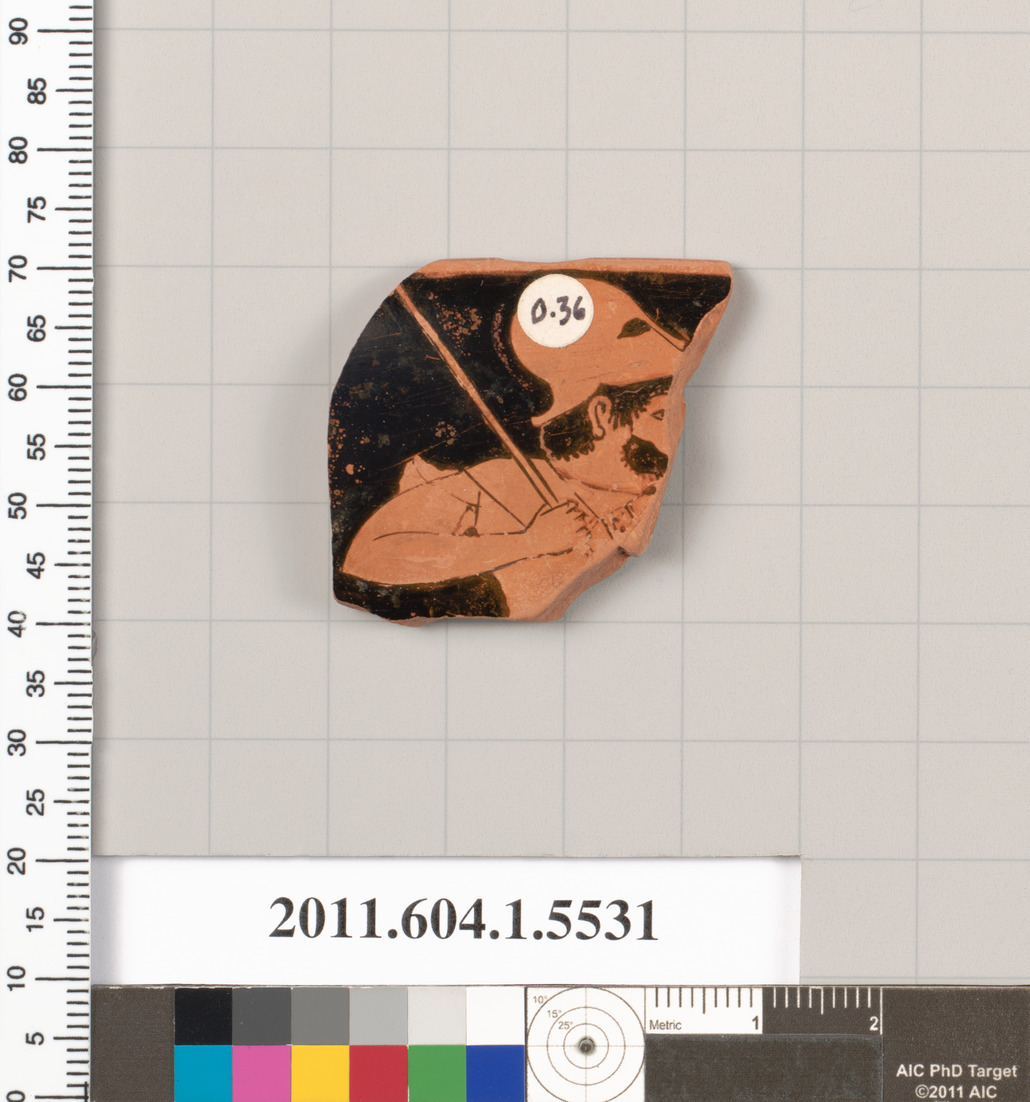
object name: kylix fragment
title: Terracotta rim fragment of a kylix (drinking cup)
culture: greek, attic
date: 490-480 BCE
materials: terracotta